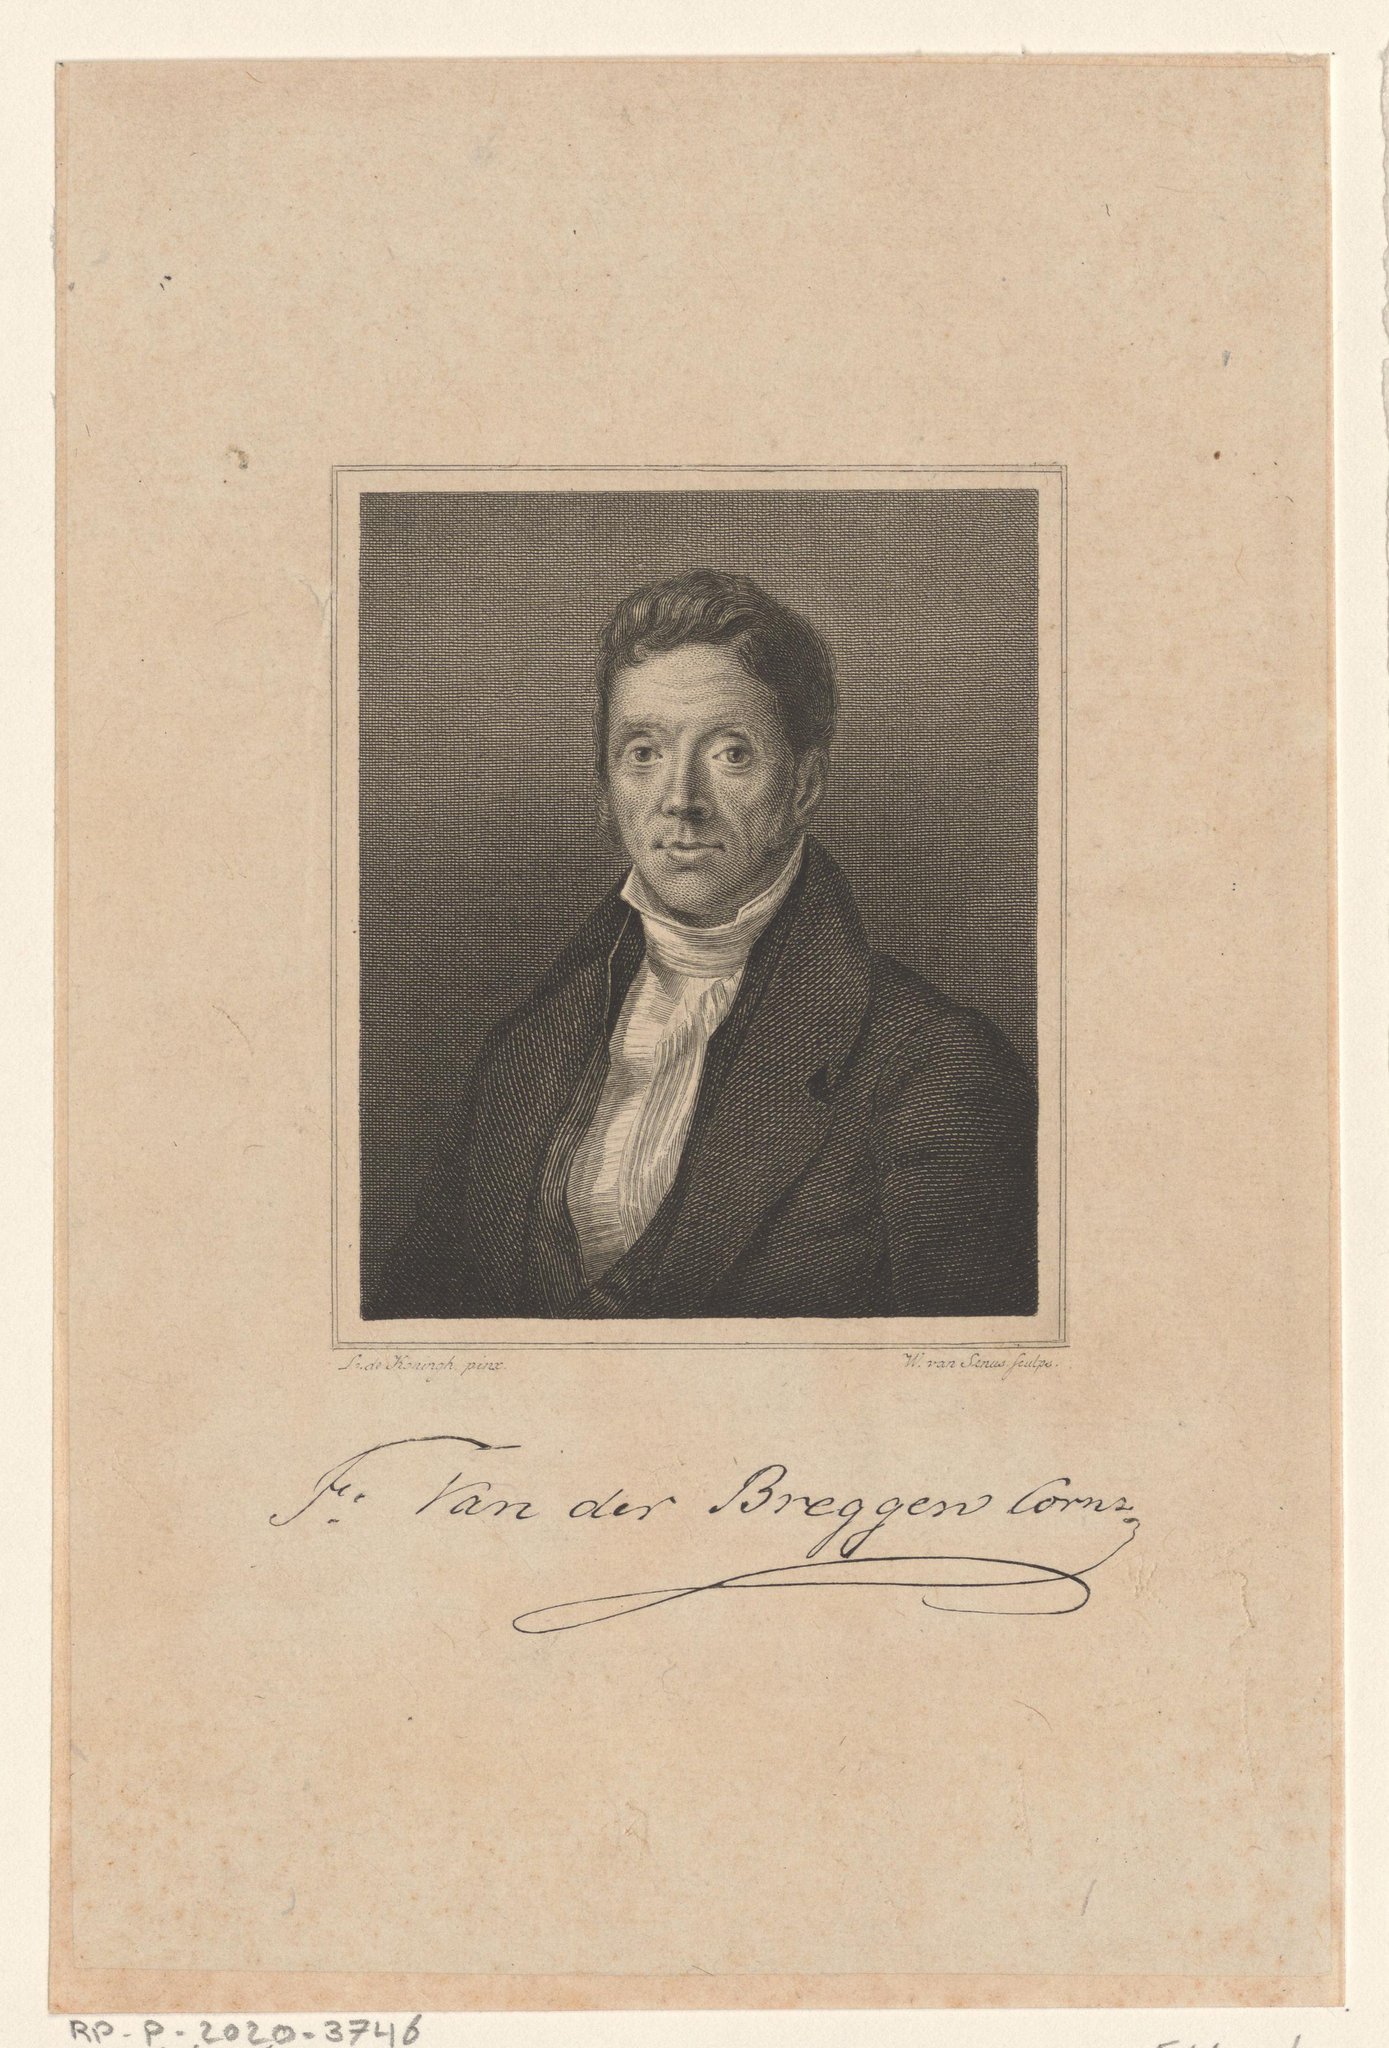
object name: print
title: Portret van Frans van der Breggen Cz.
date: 1817-1851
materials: paper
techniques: engraving, etching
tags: leiden, amsterdam, historical persons, physician, doctor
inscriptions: collector's mark: Lugt 2228